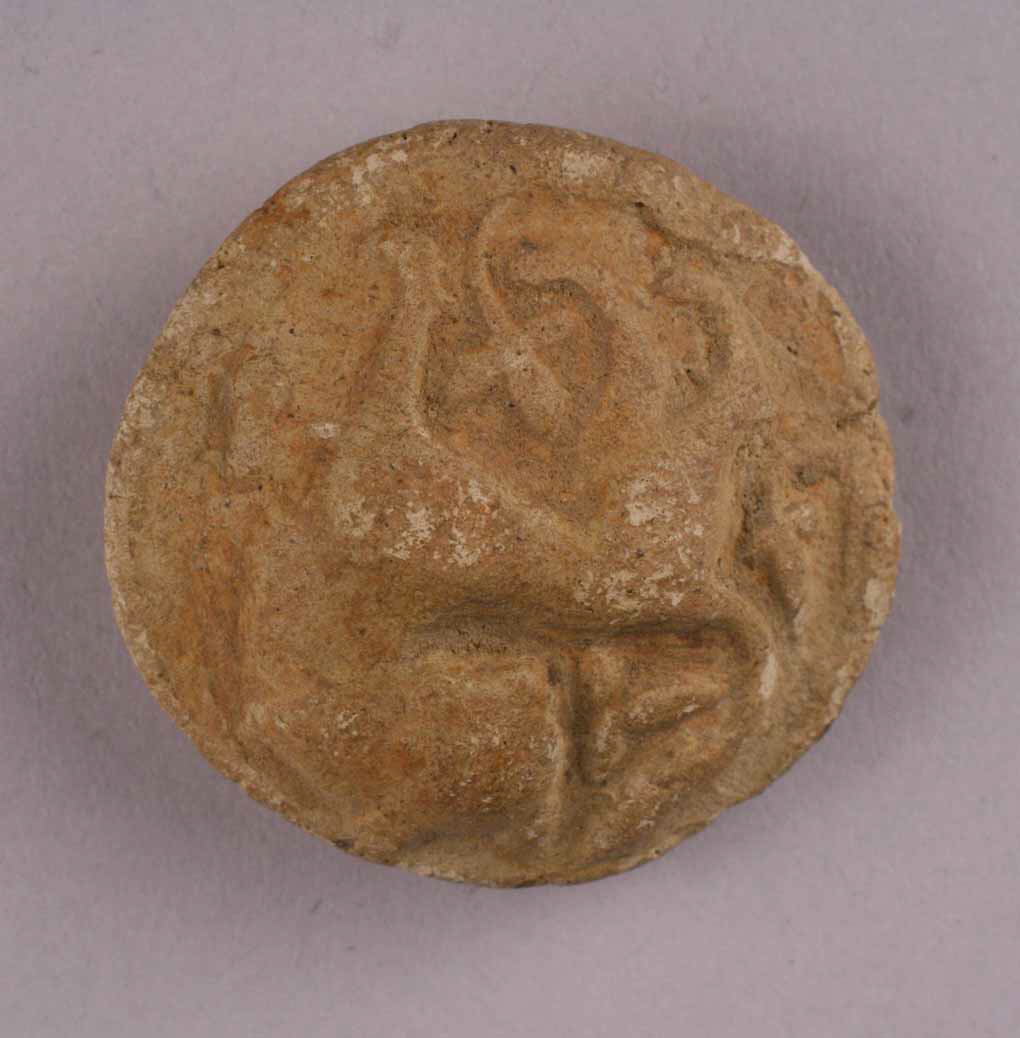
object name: roundel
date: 801-1000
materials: earthenware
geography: iran